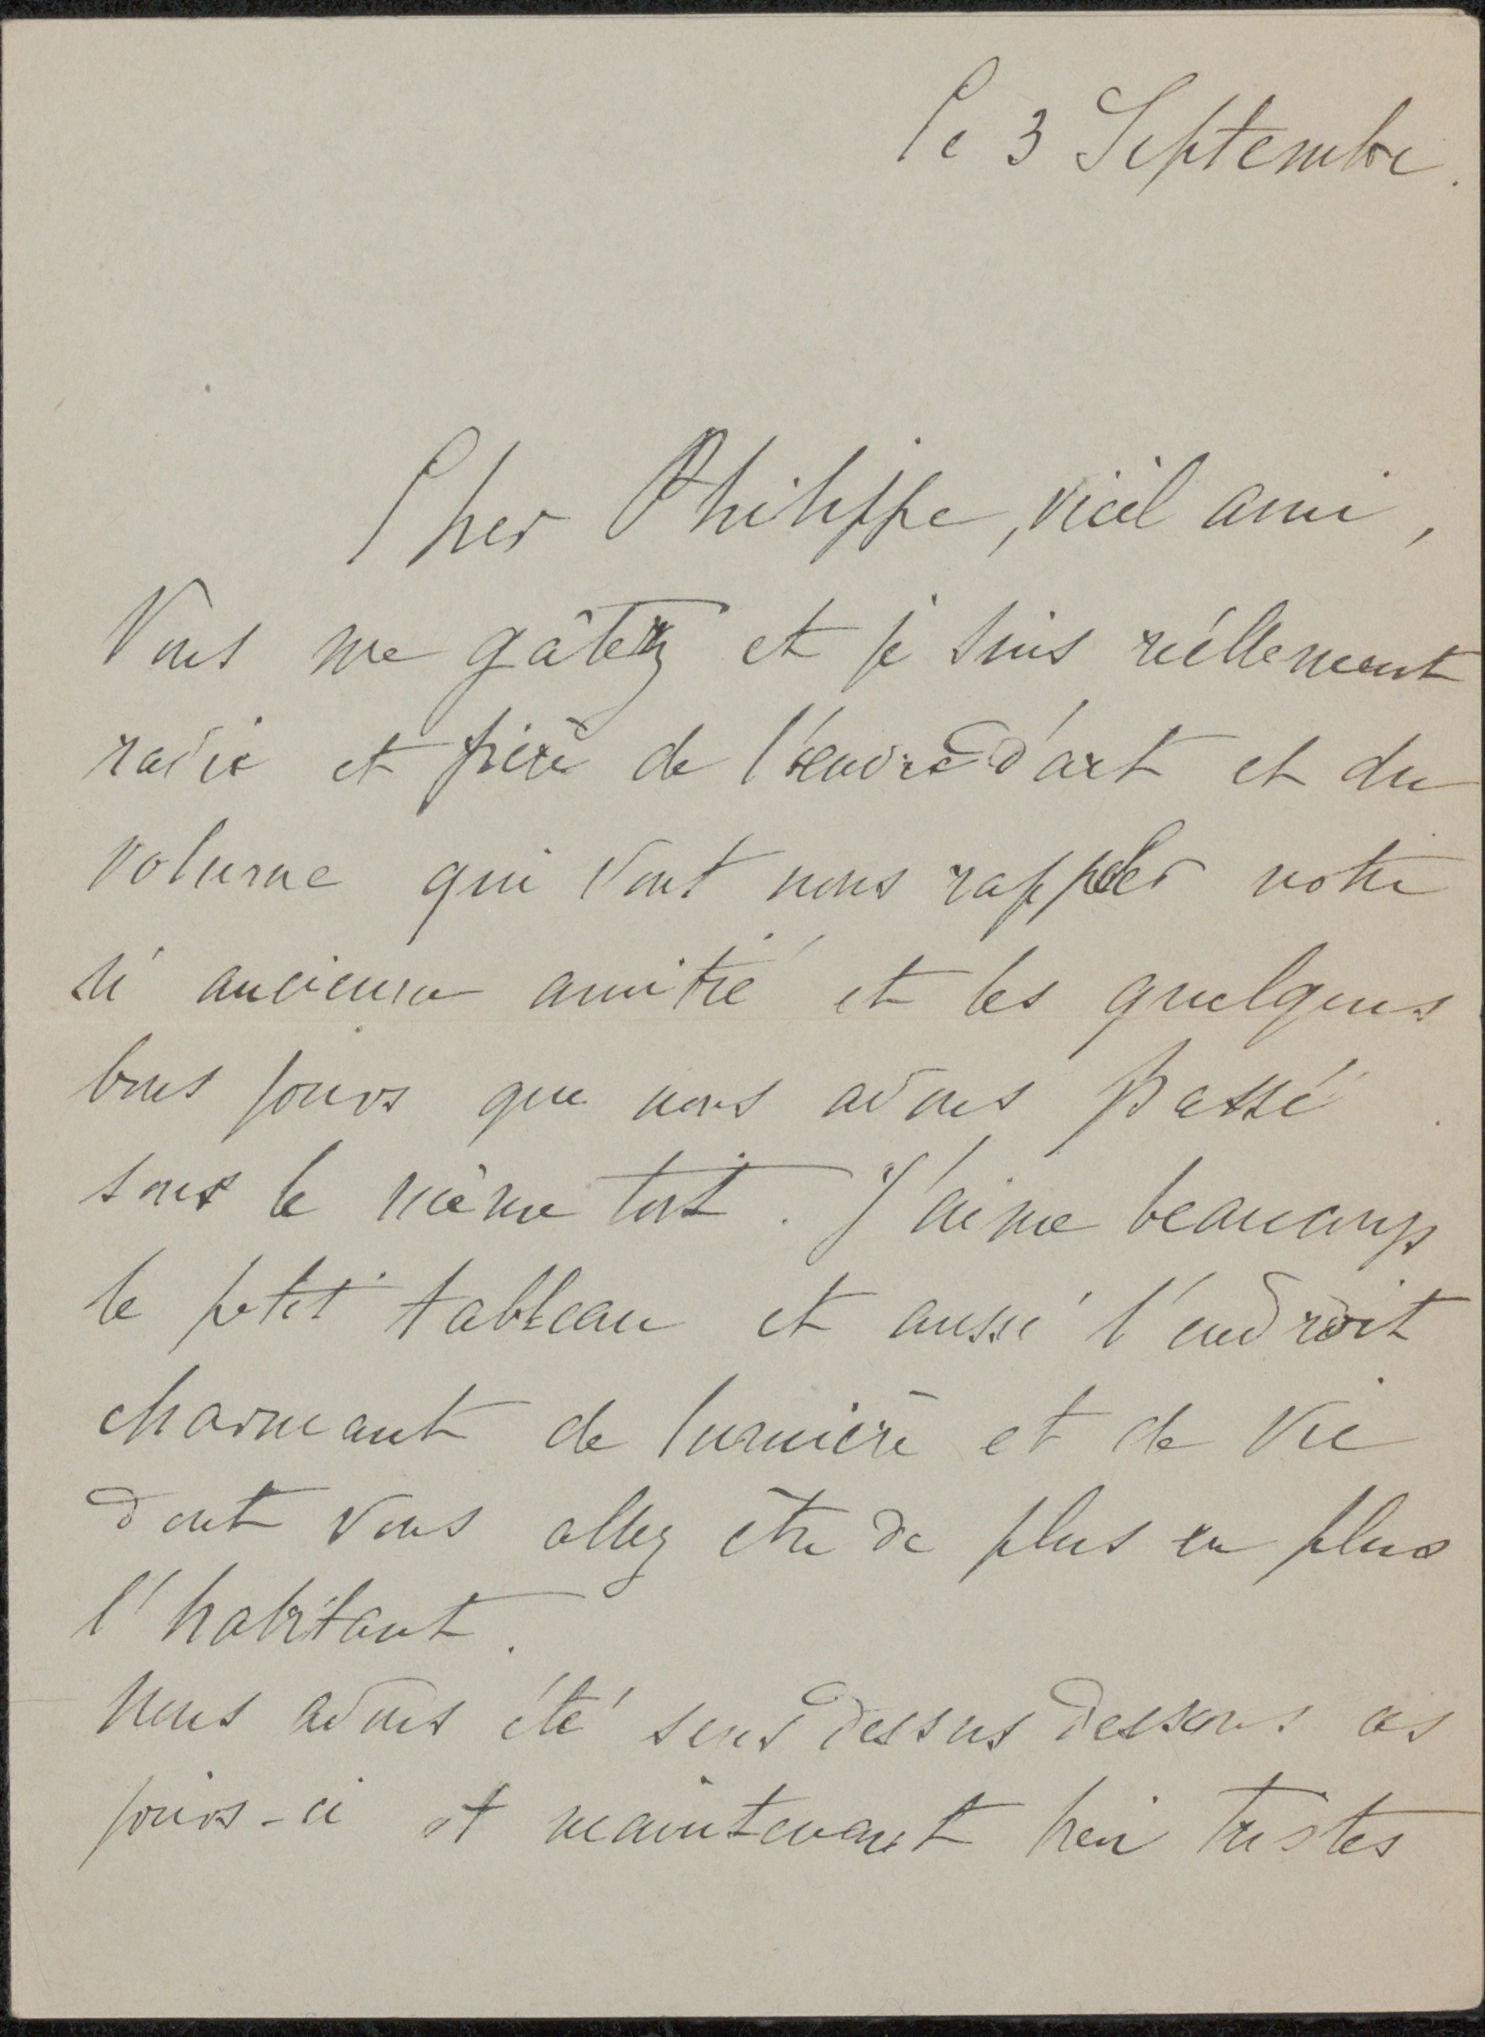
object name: letter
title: Brief aan Philip Zilcken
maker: jeanne boels de buck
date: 1923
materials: ink, paper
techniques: pen, writing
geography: brussels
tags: jeanne boels de buck, the hague, painter, draughtsman, philip zilcken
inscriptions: collector's mark: ‘RPK’